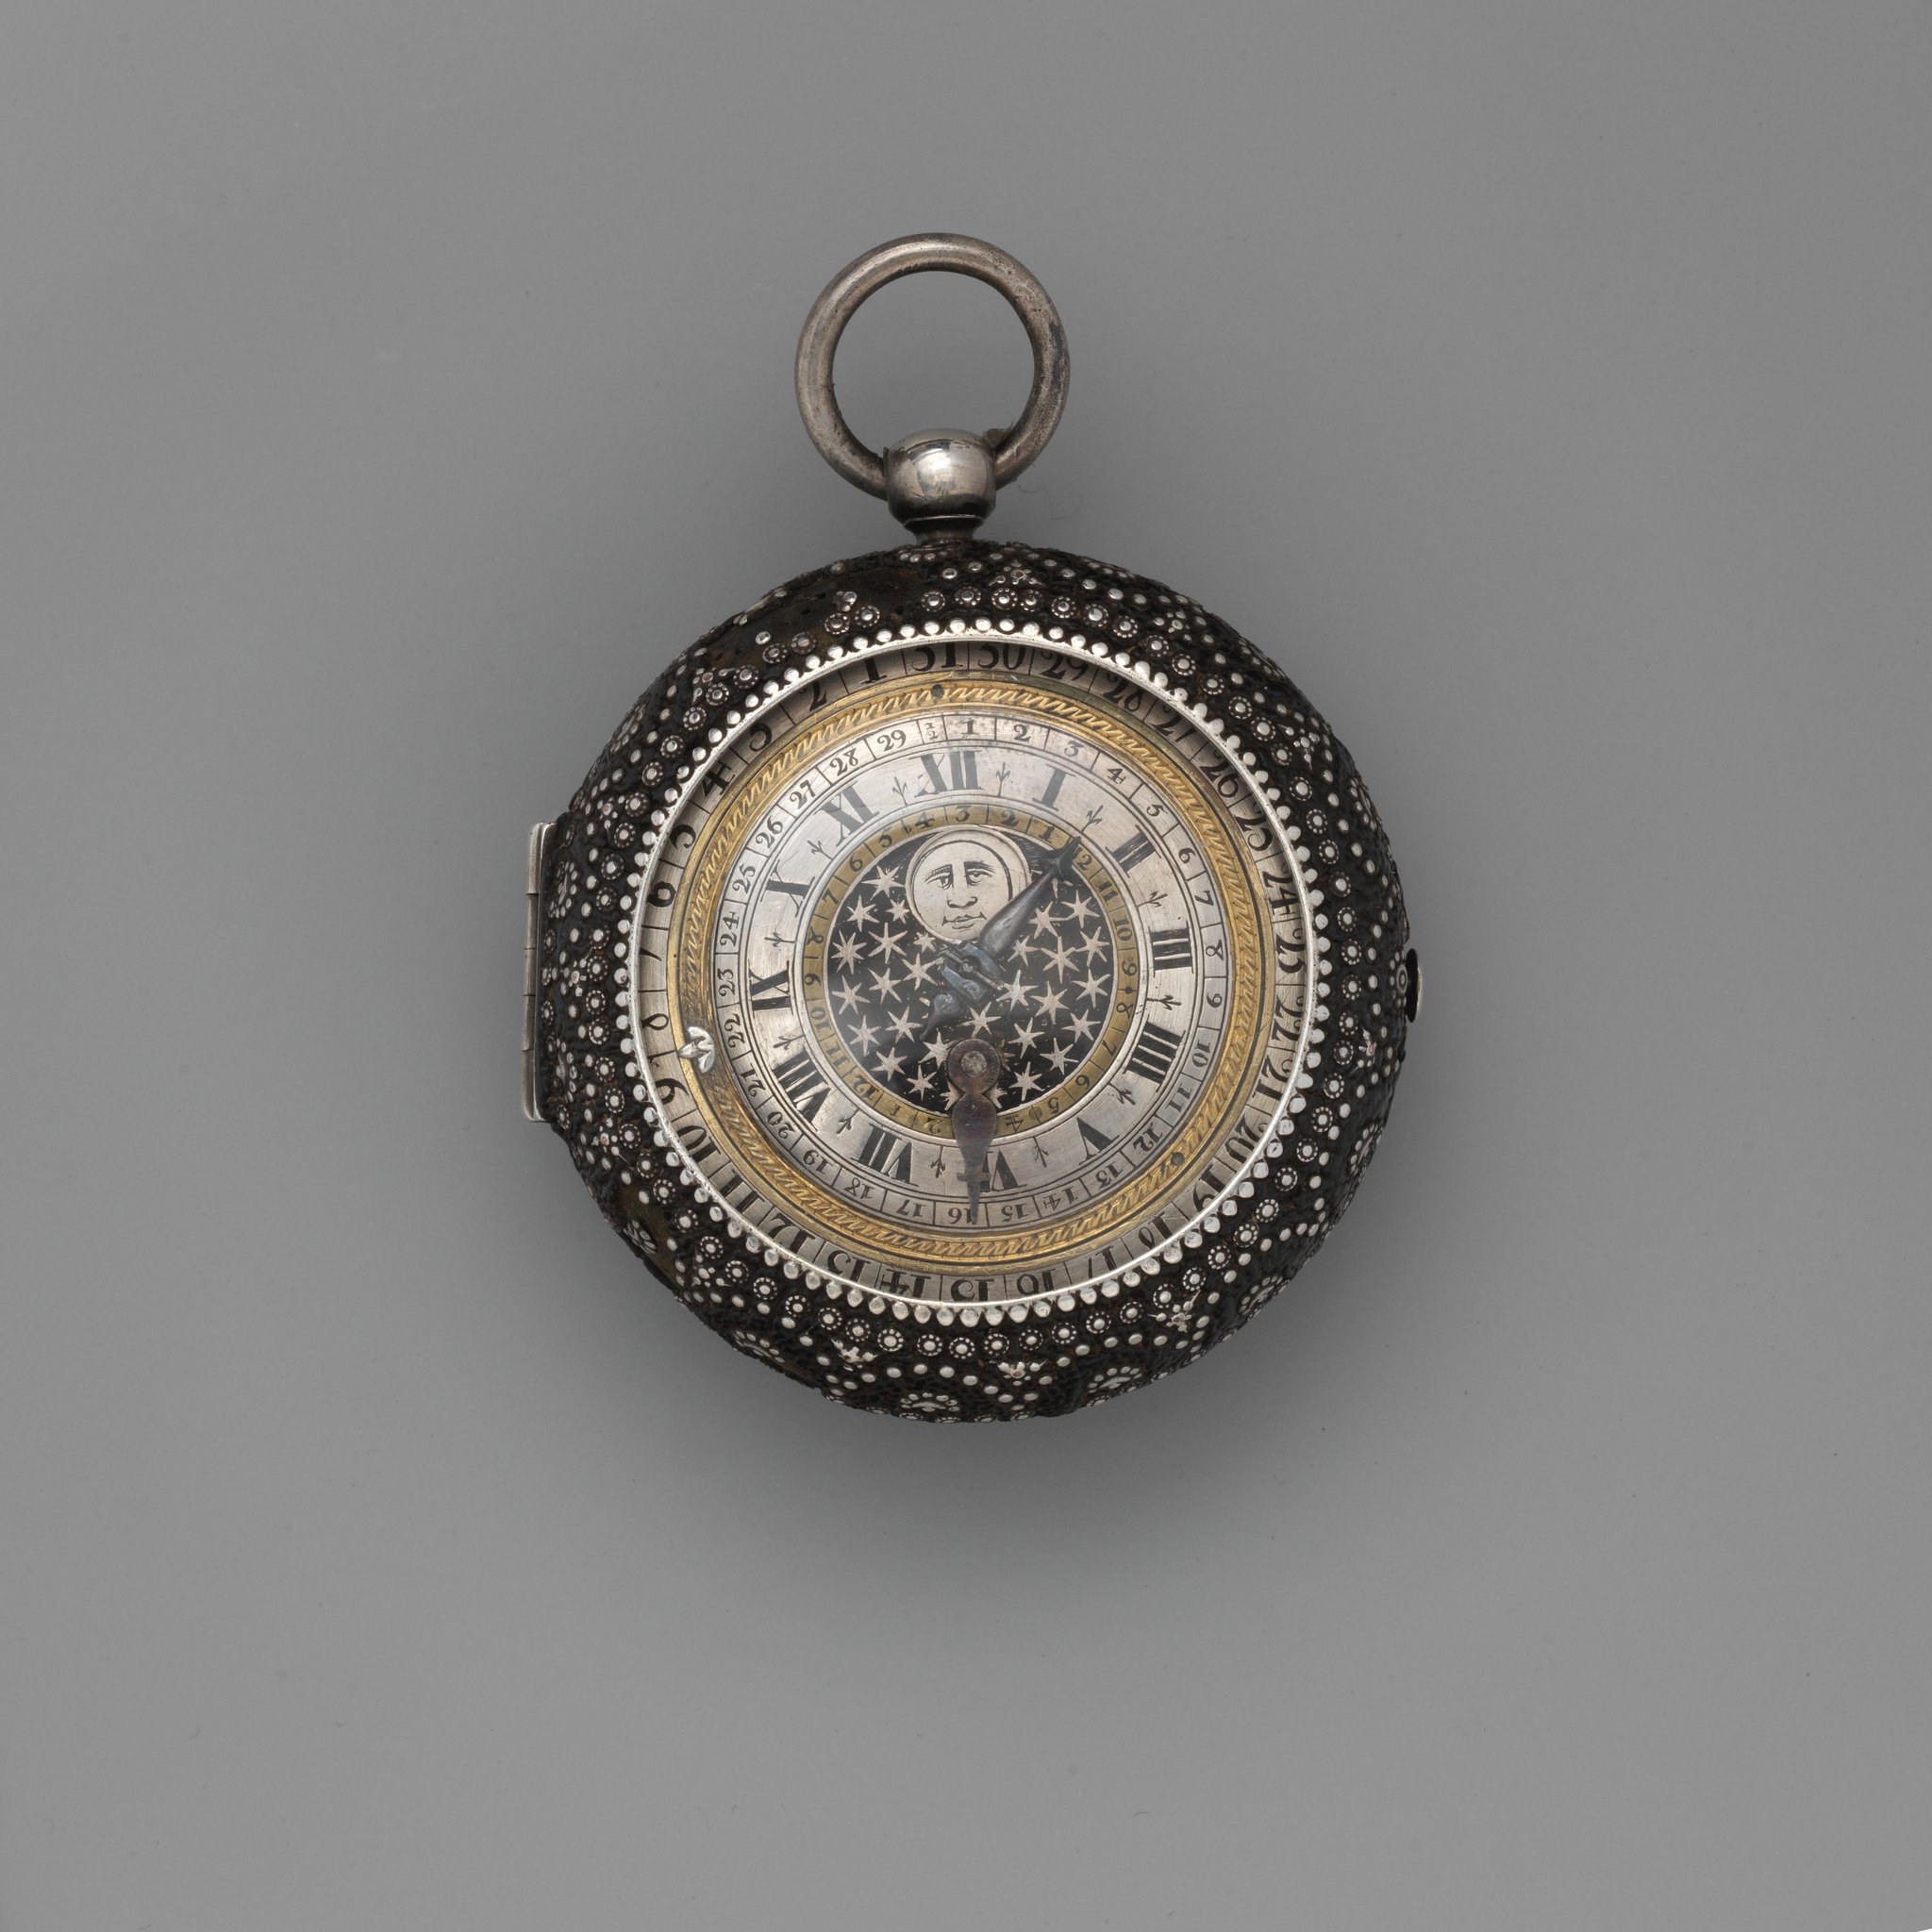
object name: calendar watch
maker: thomas alcock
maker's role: maker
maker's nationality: british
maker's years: 1630-1688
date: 1650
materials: brass, gilt, leather, silver, steel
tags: calendars